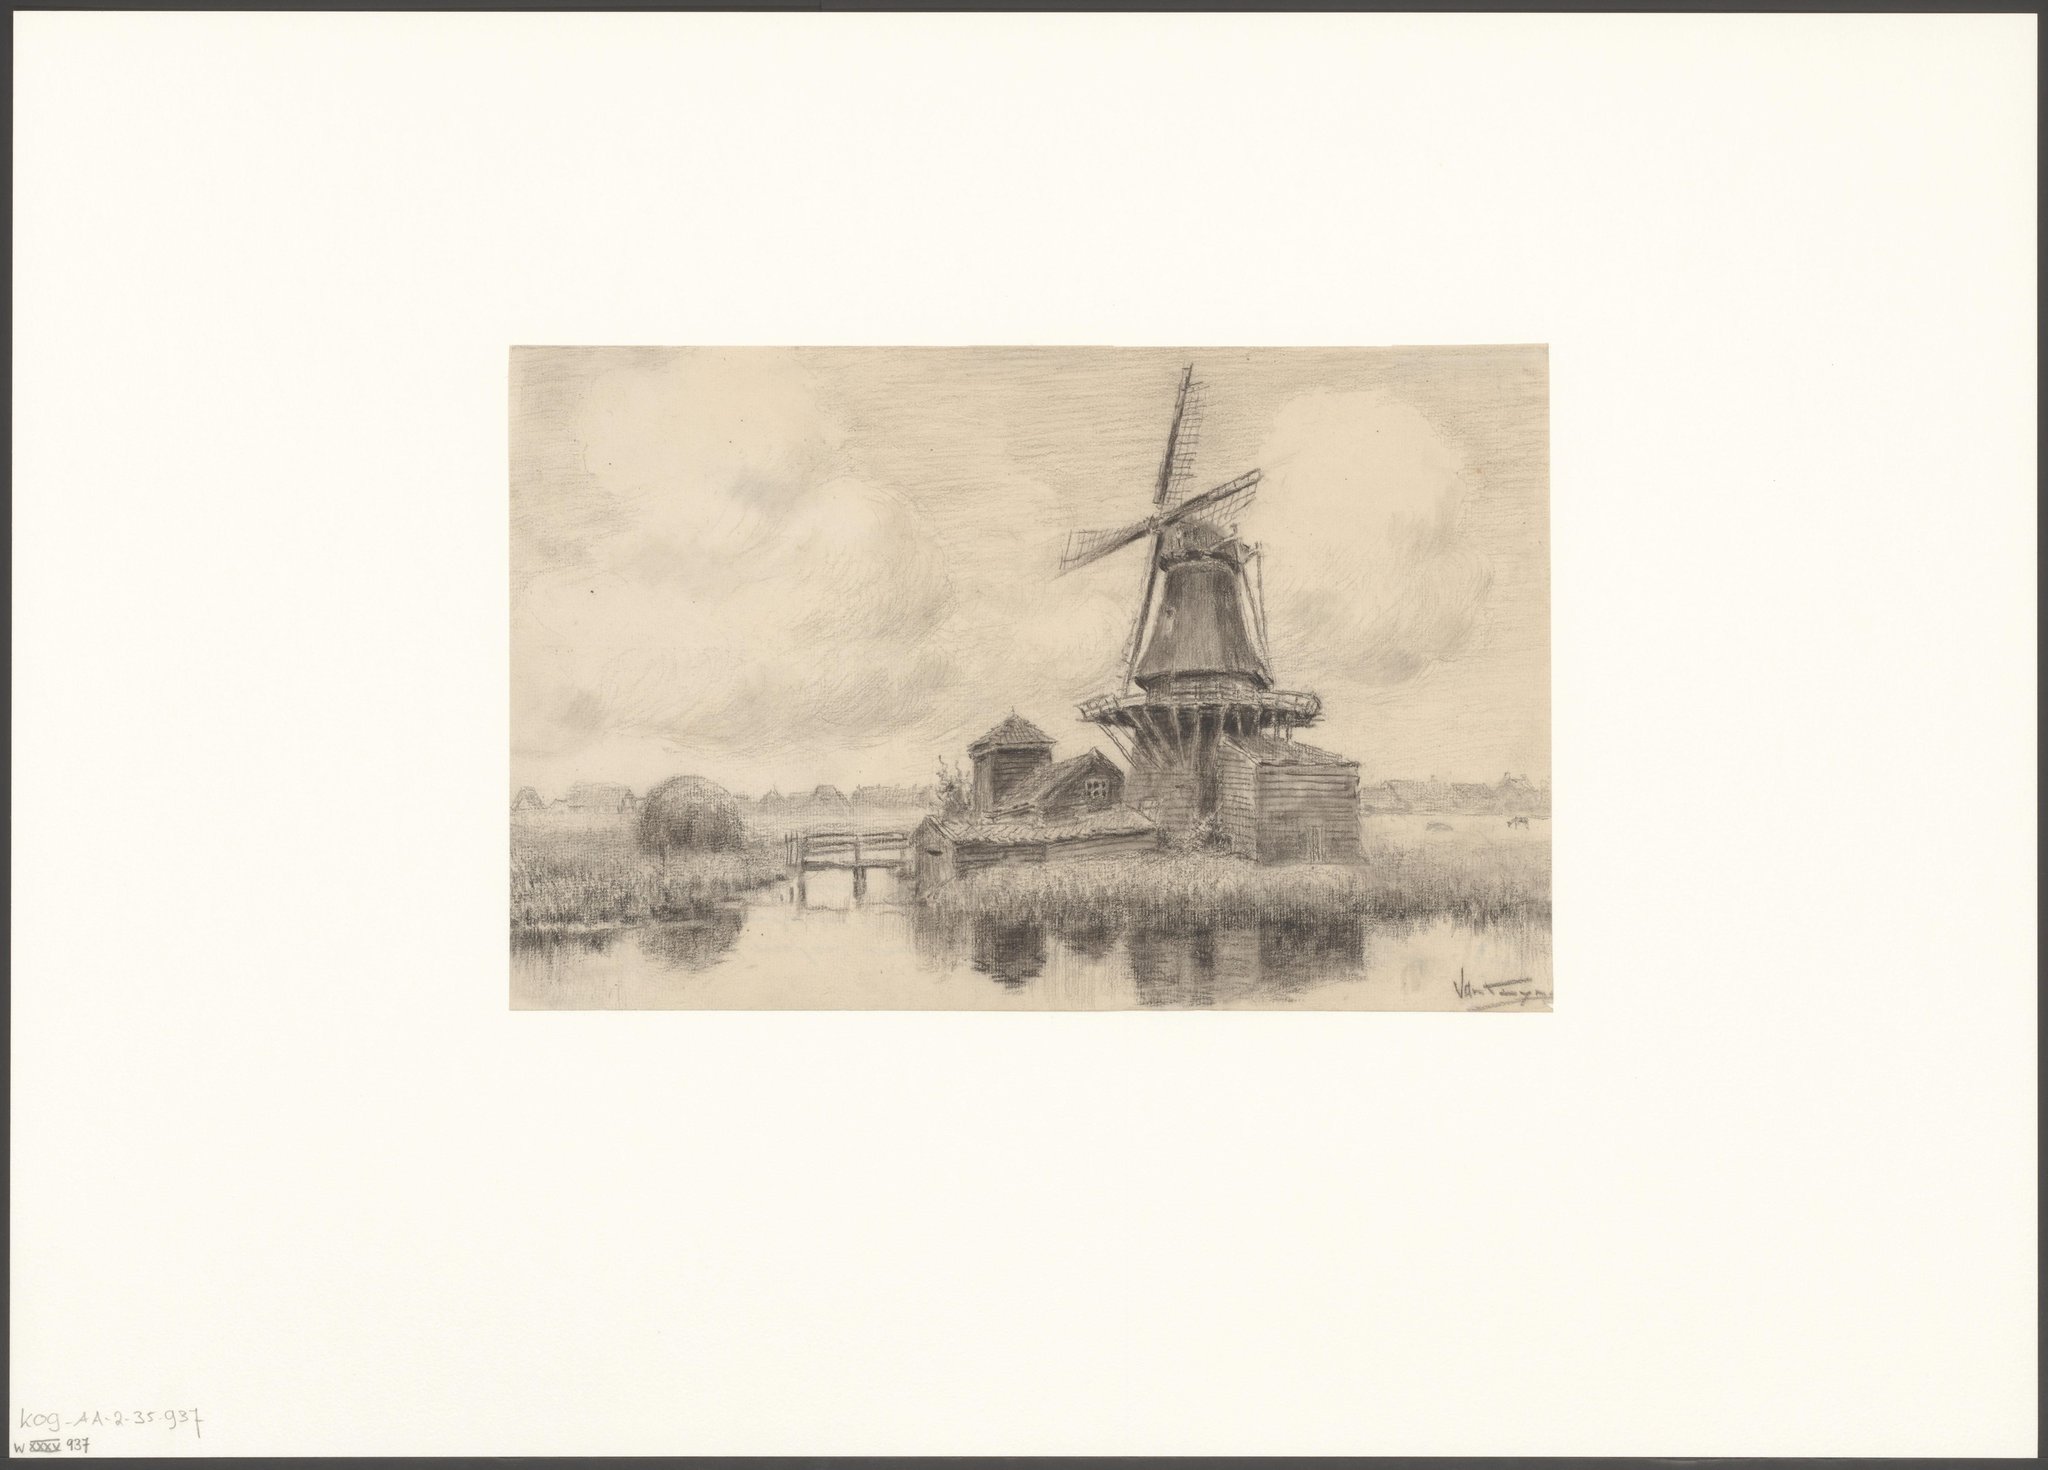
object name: drawing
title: Gezicht op molen De Pauw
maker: anthonie van teijn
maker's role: draughtsman, painter, print maker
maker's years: 1863-1943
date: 1906-1928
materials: chalk, paper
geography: amsterdam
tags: canal, village, windmill in landscape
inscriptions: inscription: ‘De Pelmolen van (...) genaamd "de Pauw"’, signature: ‘VanTeyne’, collector's mark: Lugt 800a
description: Tekening binnen de Atlas Van Eck ingedeeld op wijknummer 35.